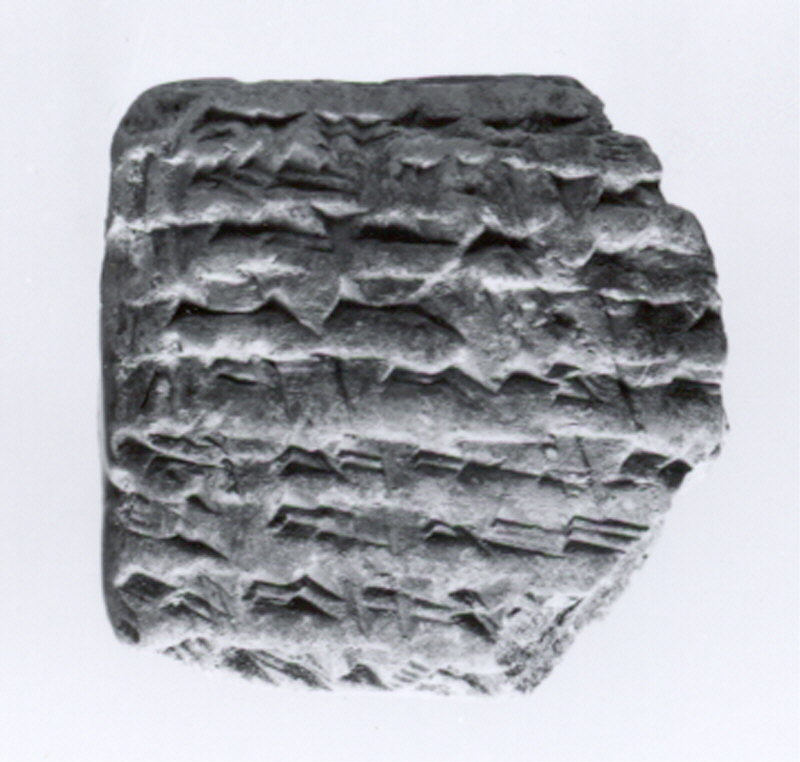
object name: cuneiform tablet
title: Cuneiform tablet: promissory note for barley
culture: babylonian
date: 555-539 BCE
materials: clay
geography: mesopotamia